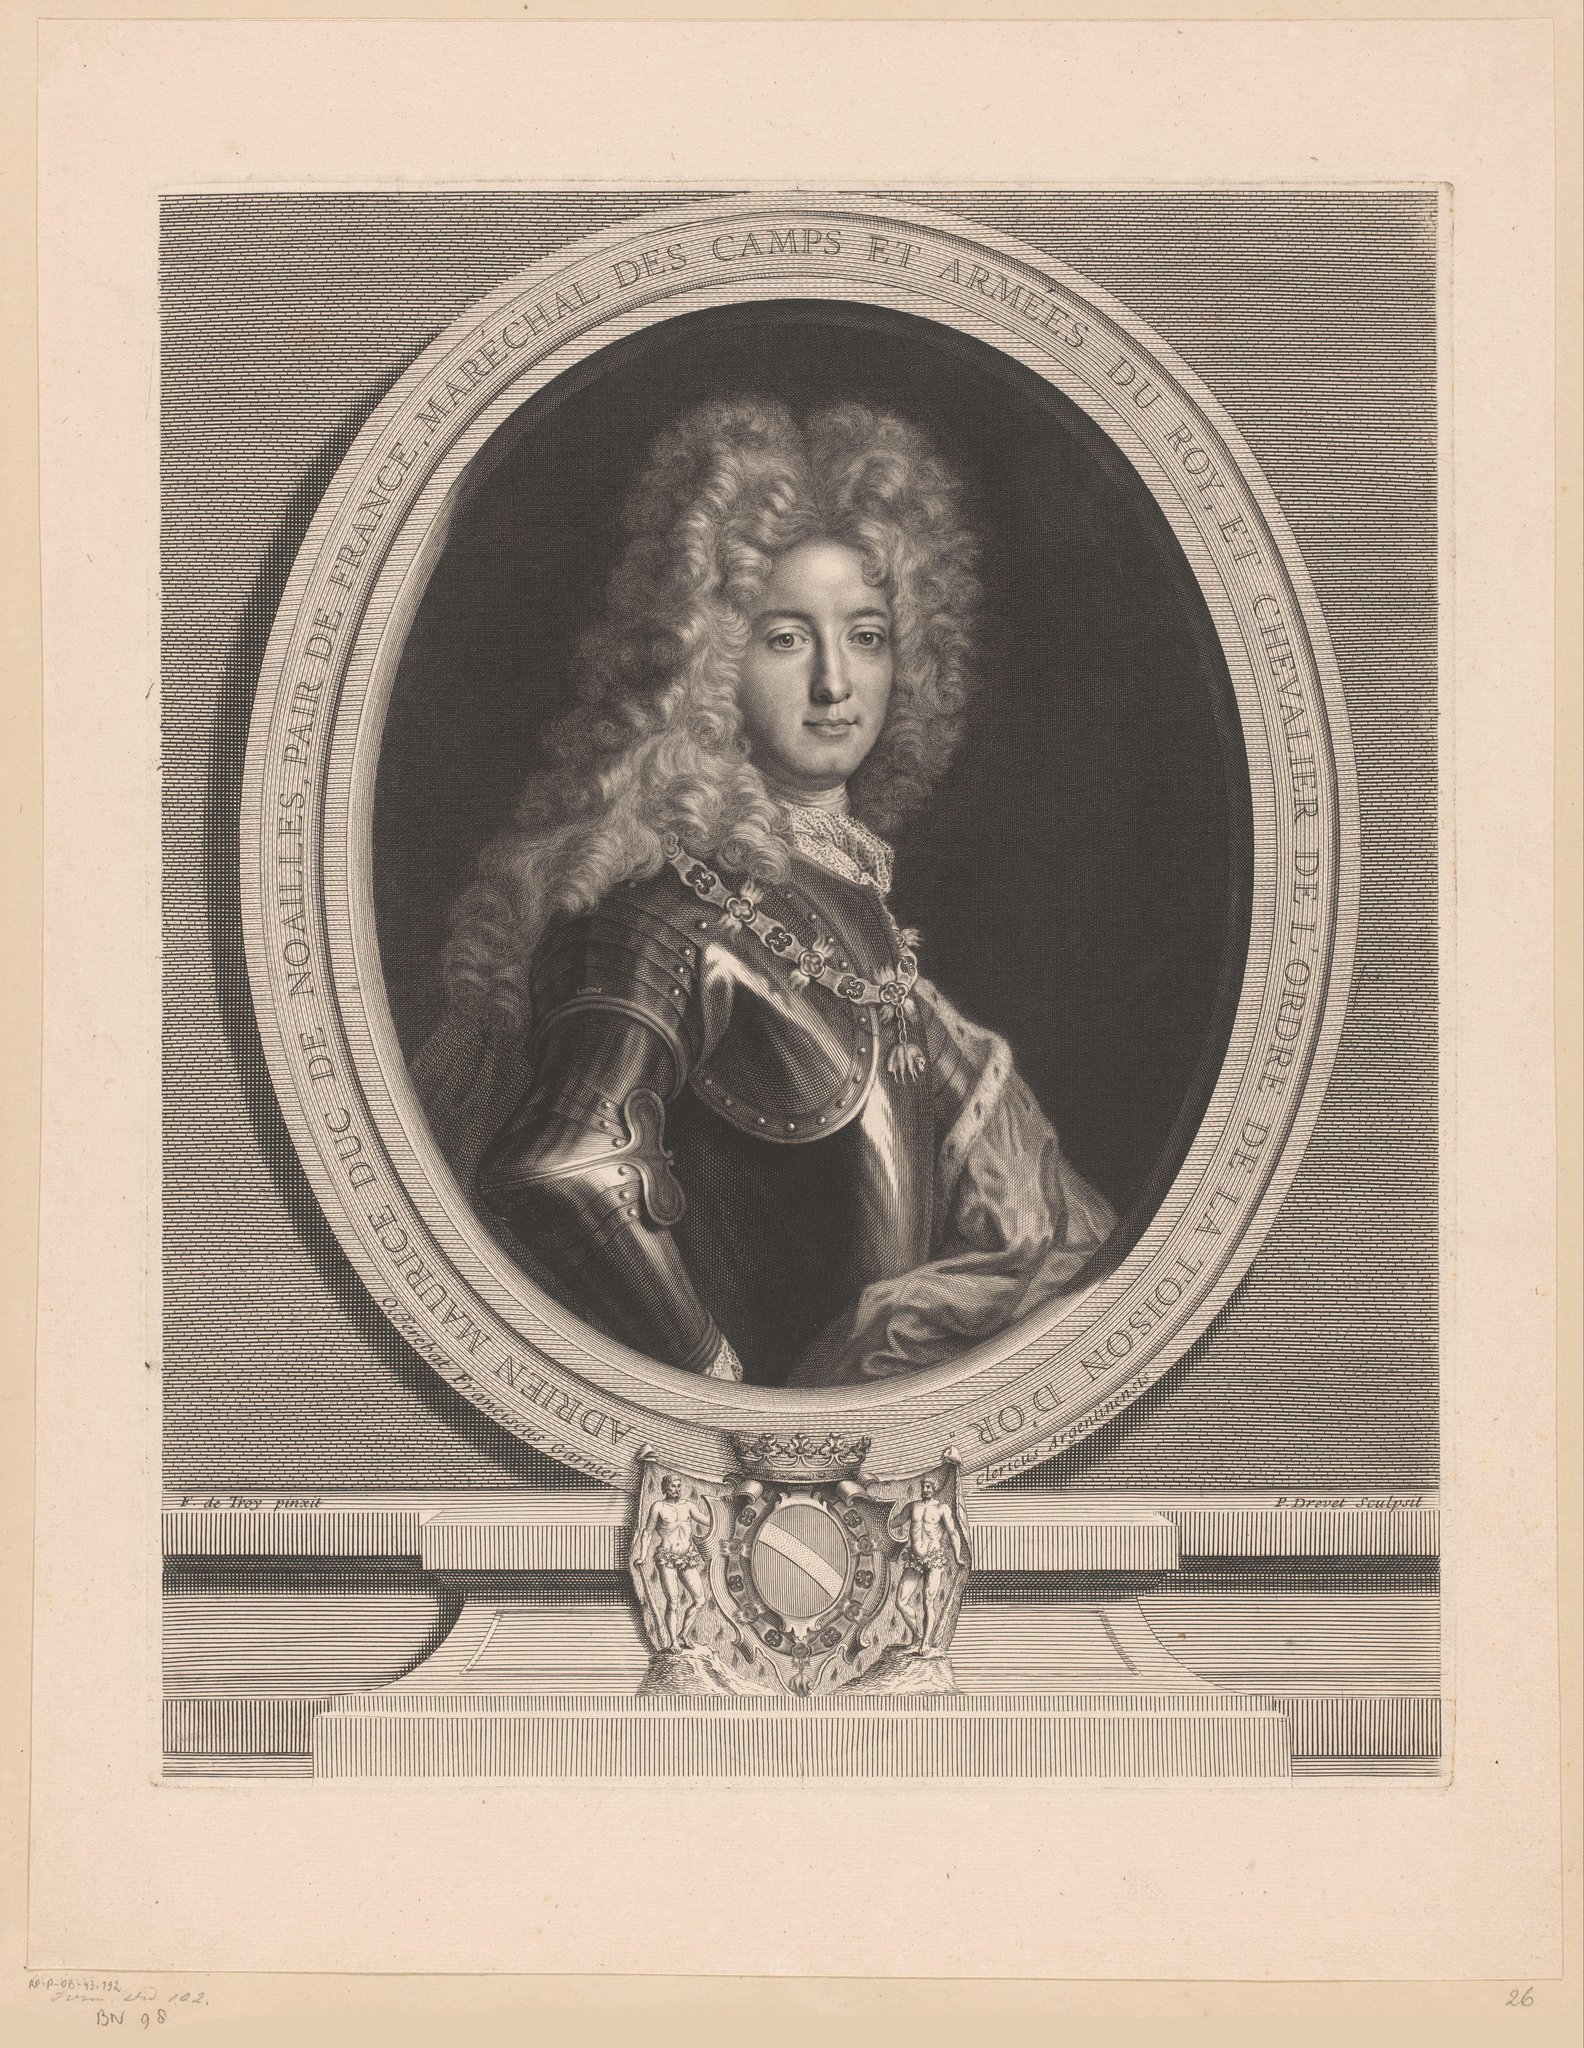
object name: print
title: Portret van Adrien Maurice de Noailles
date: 1704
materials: paper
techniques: engraving, etching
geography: france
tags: armour, historical persons, diplomacy, diplomat, knighthood order of the golden fleece - insignia of a knighthood order, e.g.: badge, chain (with name of order)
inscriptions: collector's mark: Lugt 240